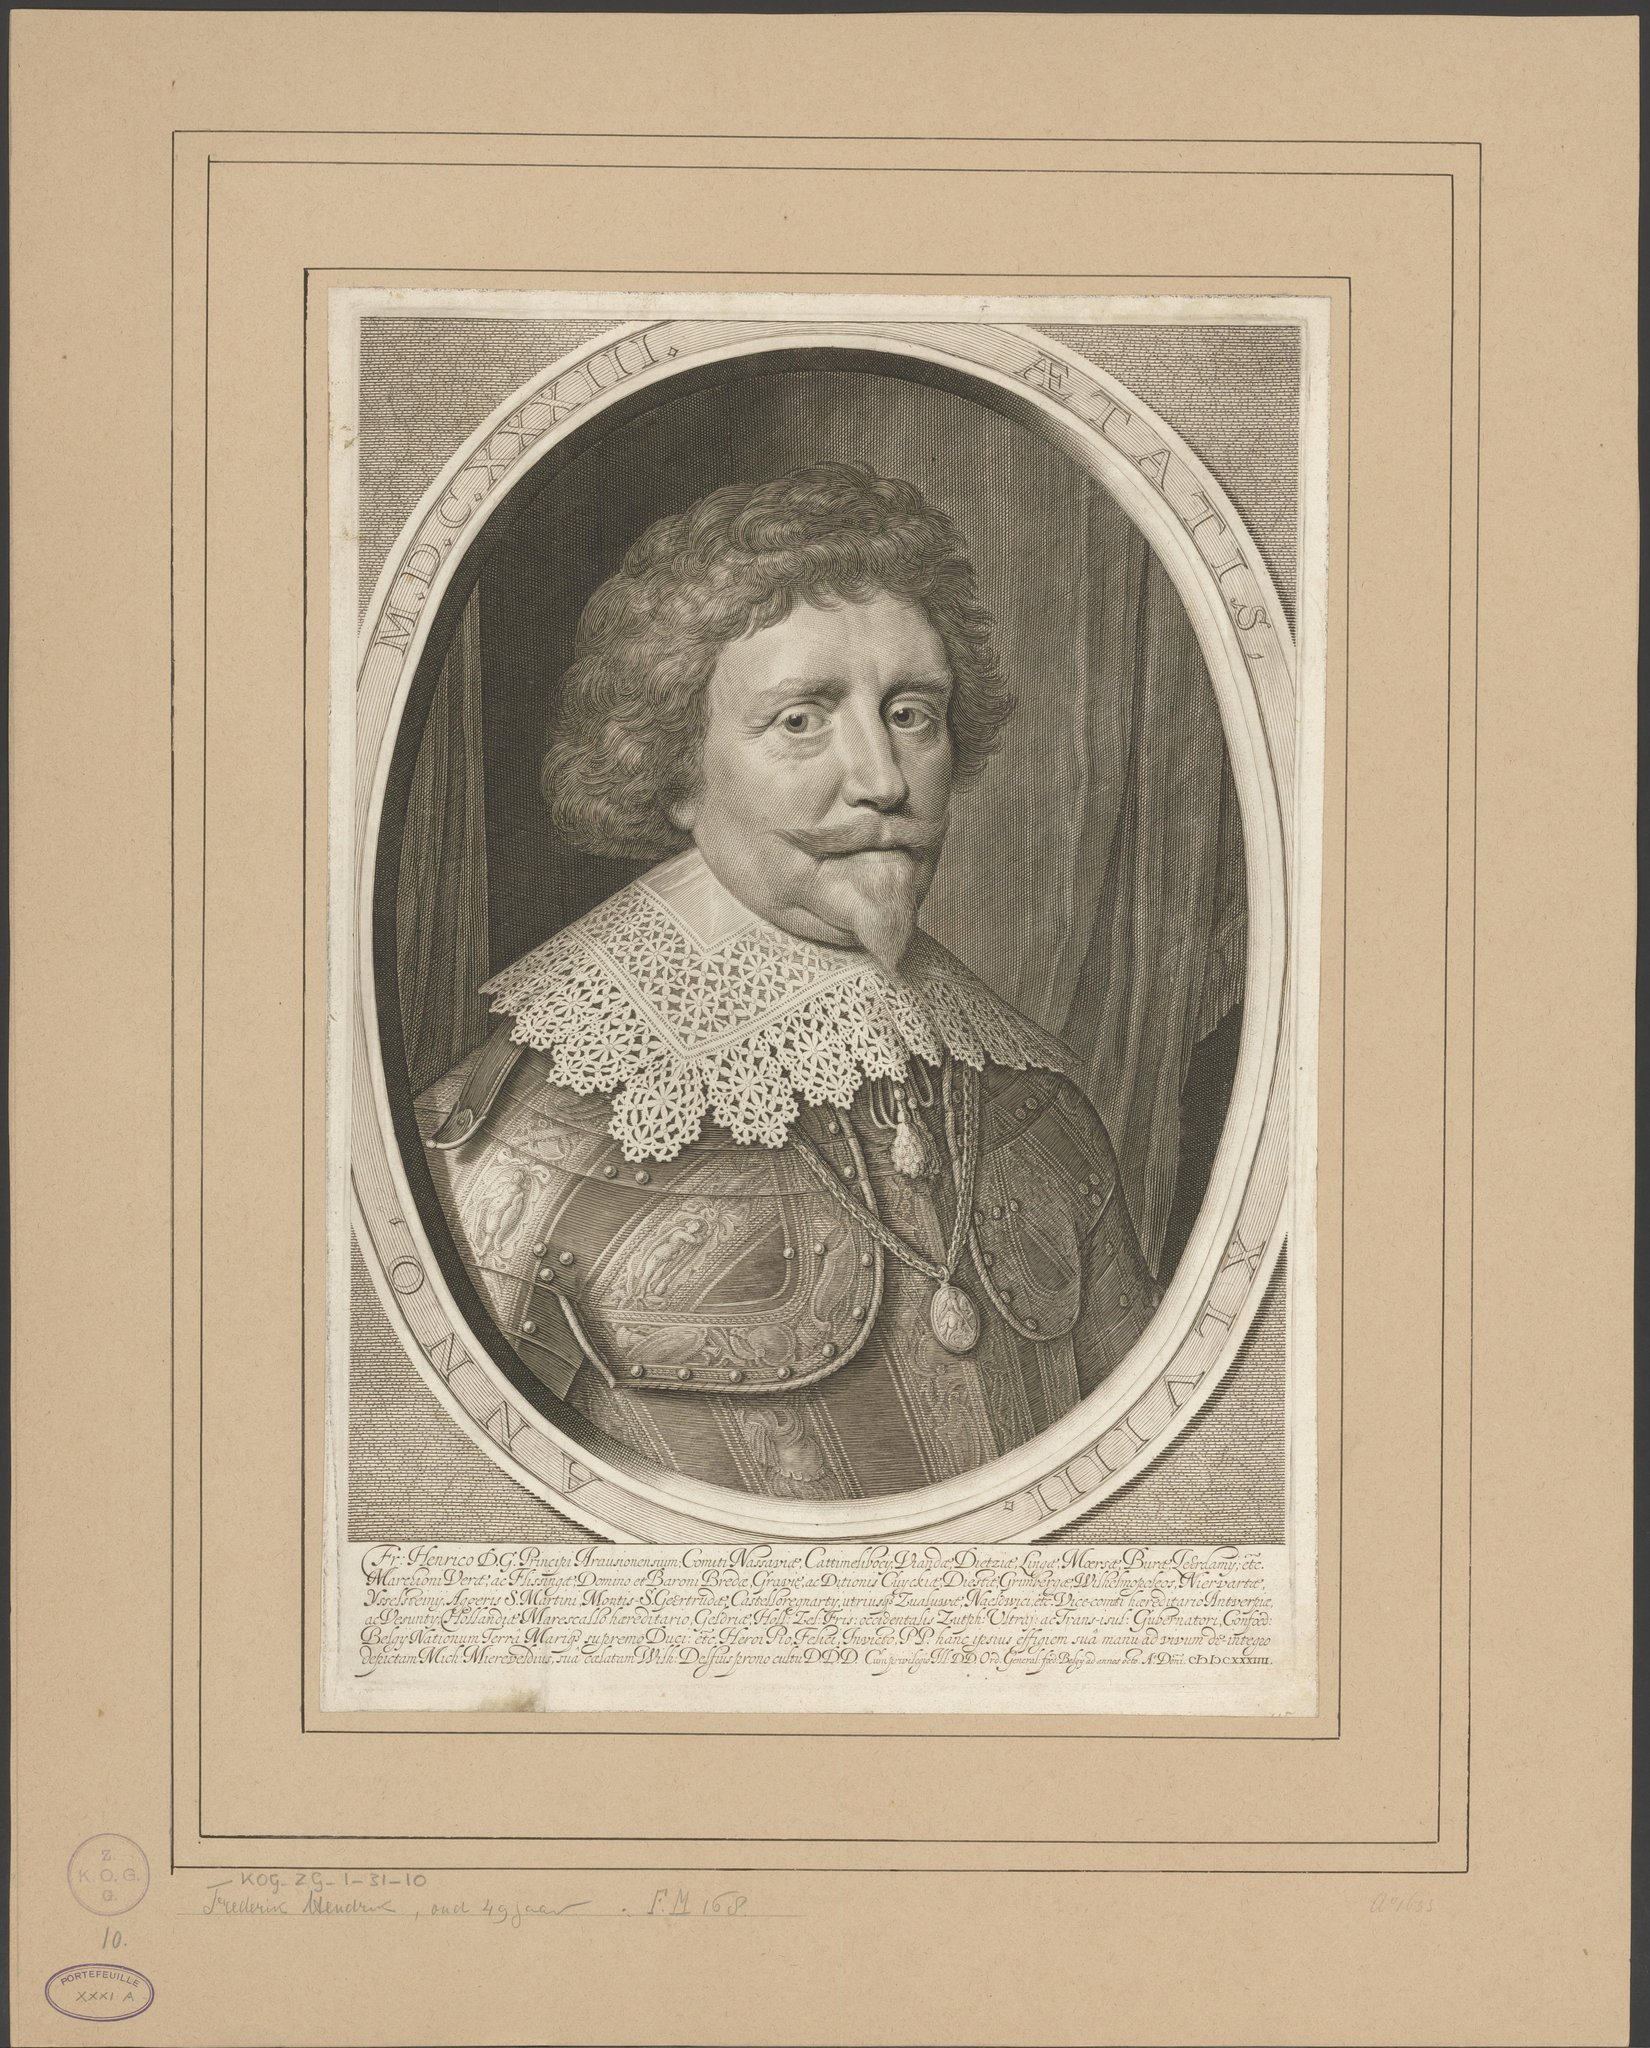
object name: print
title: Portret van Frederik Hendrik, prins van Oranje, op 48-jarige leeftijd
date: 1633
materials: paper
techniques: engraving, etching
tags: delft, the hague, frederick henry (prince of orange), knighthood order (garter) - insignia of a knighthood order, e.g.: badge, chain, historical persons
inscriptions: collector's mark: Lugt 1641, stamp, collector's mark: Lugt 1641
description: Portret van Frederik Hendrik in een ovaal met randschrift. In de ondermarge zes regels Latijnse tekst. Onderwerpsrubrieken binnen de Atlas Zeden en Gewoonten: Portretten, Portretten van Vorsten uit het huis van Oranje, Regeerende Vorsten, Stadhouders van Holland, Zeeland en West-Friesland.